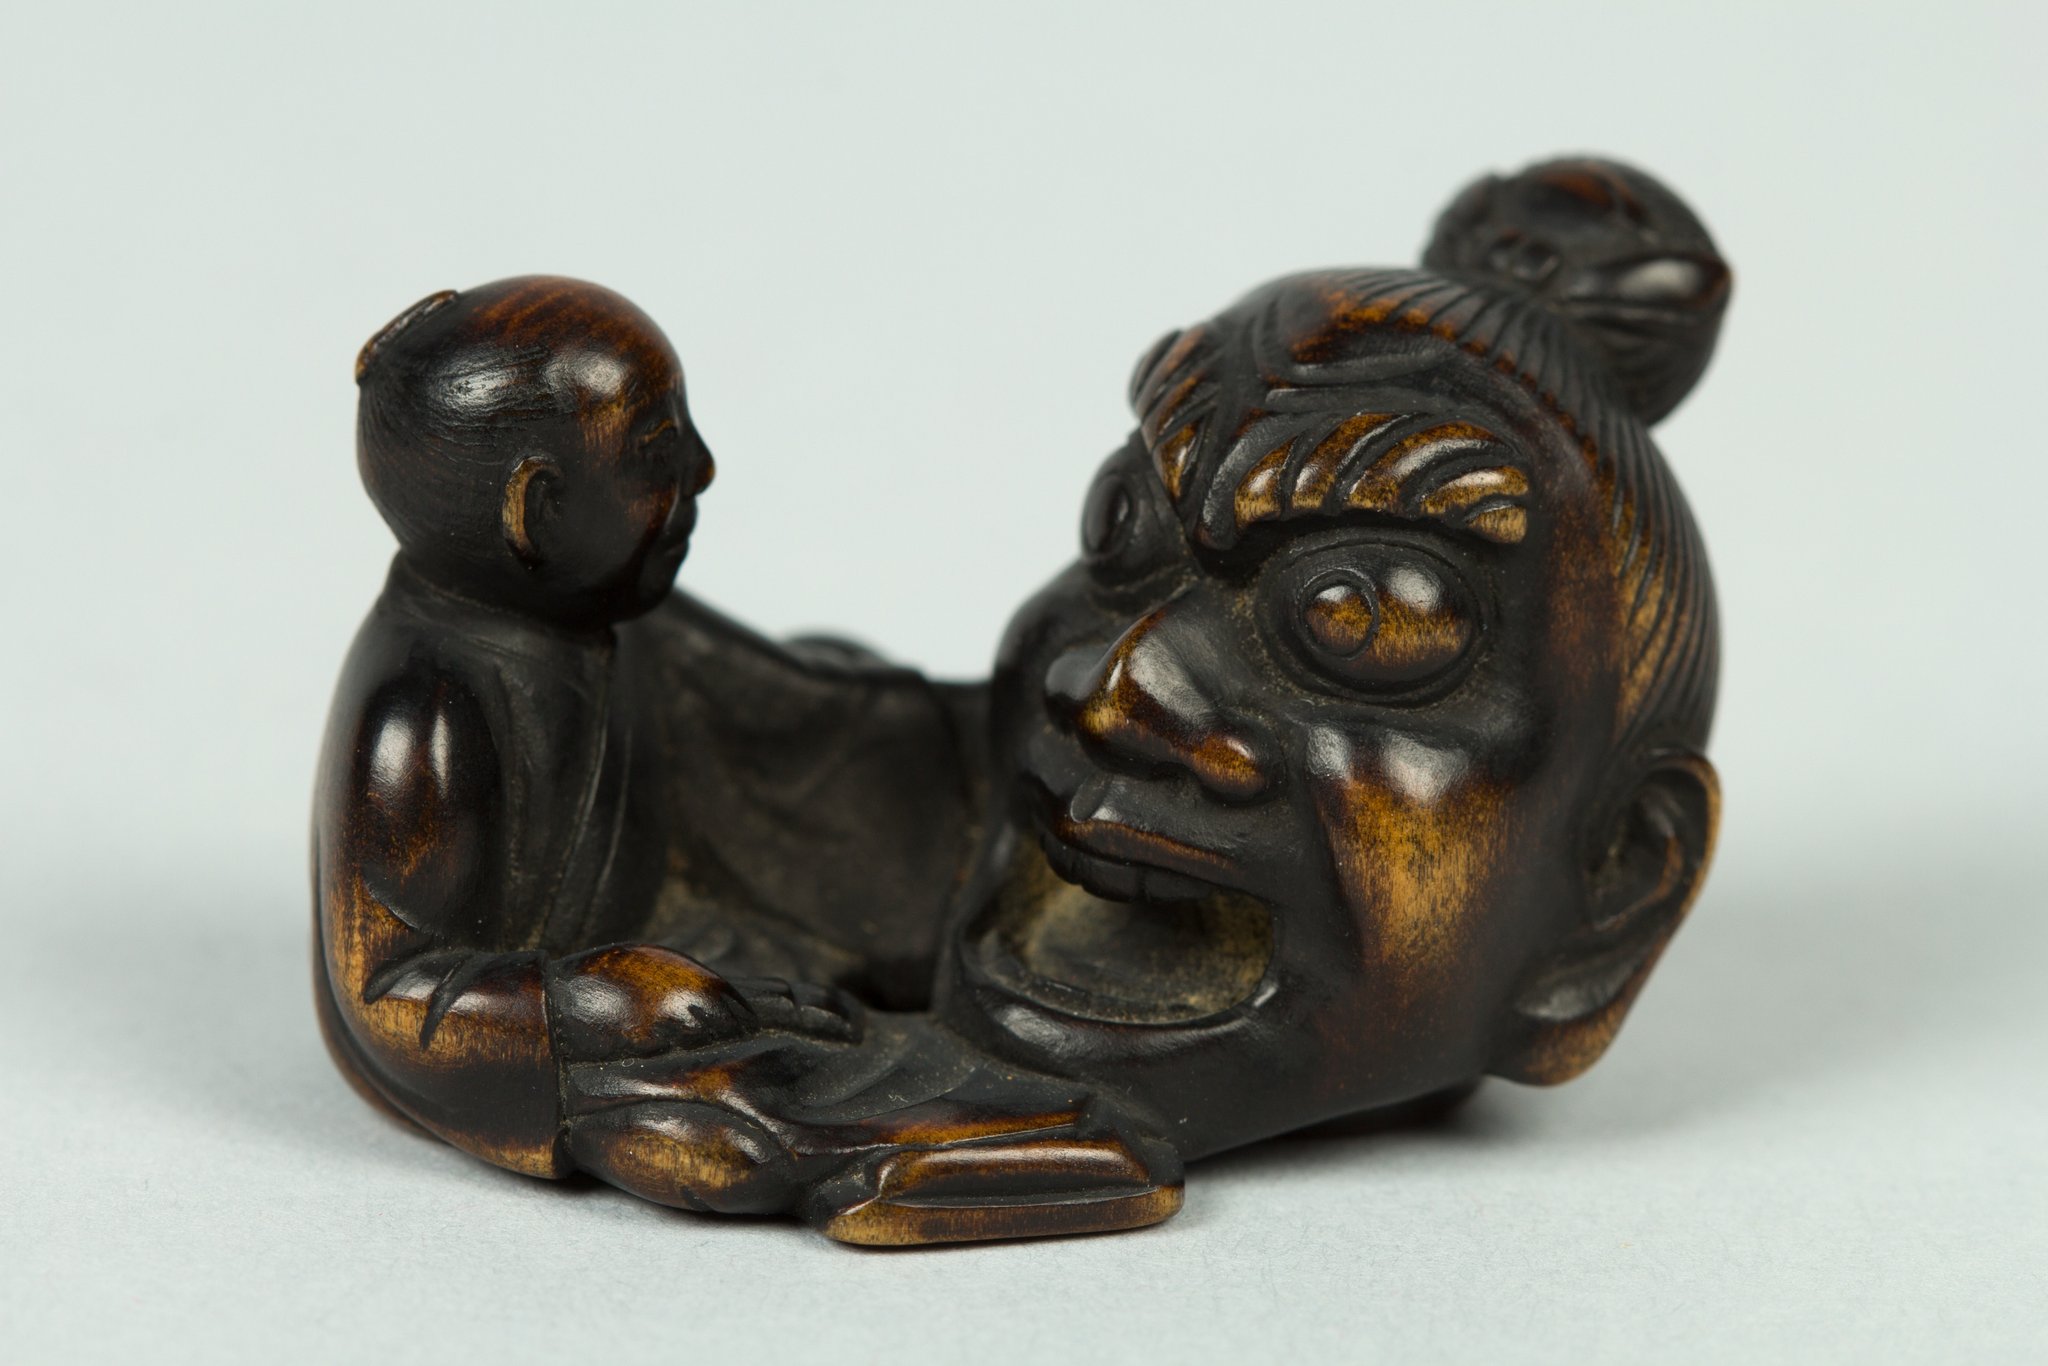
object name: netsuke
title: Netsuke of Sculptor Modelling a Large Head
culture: japanese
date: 1801-1900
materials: wood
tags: masks,children